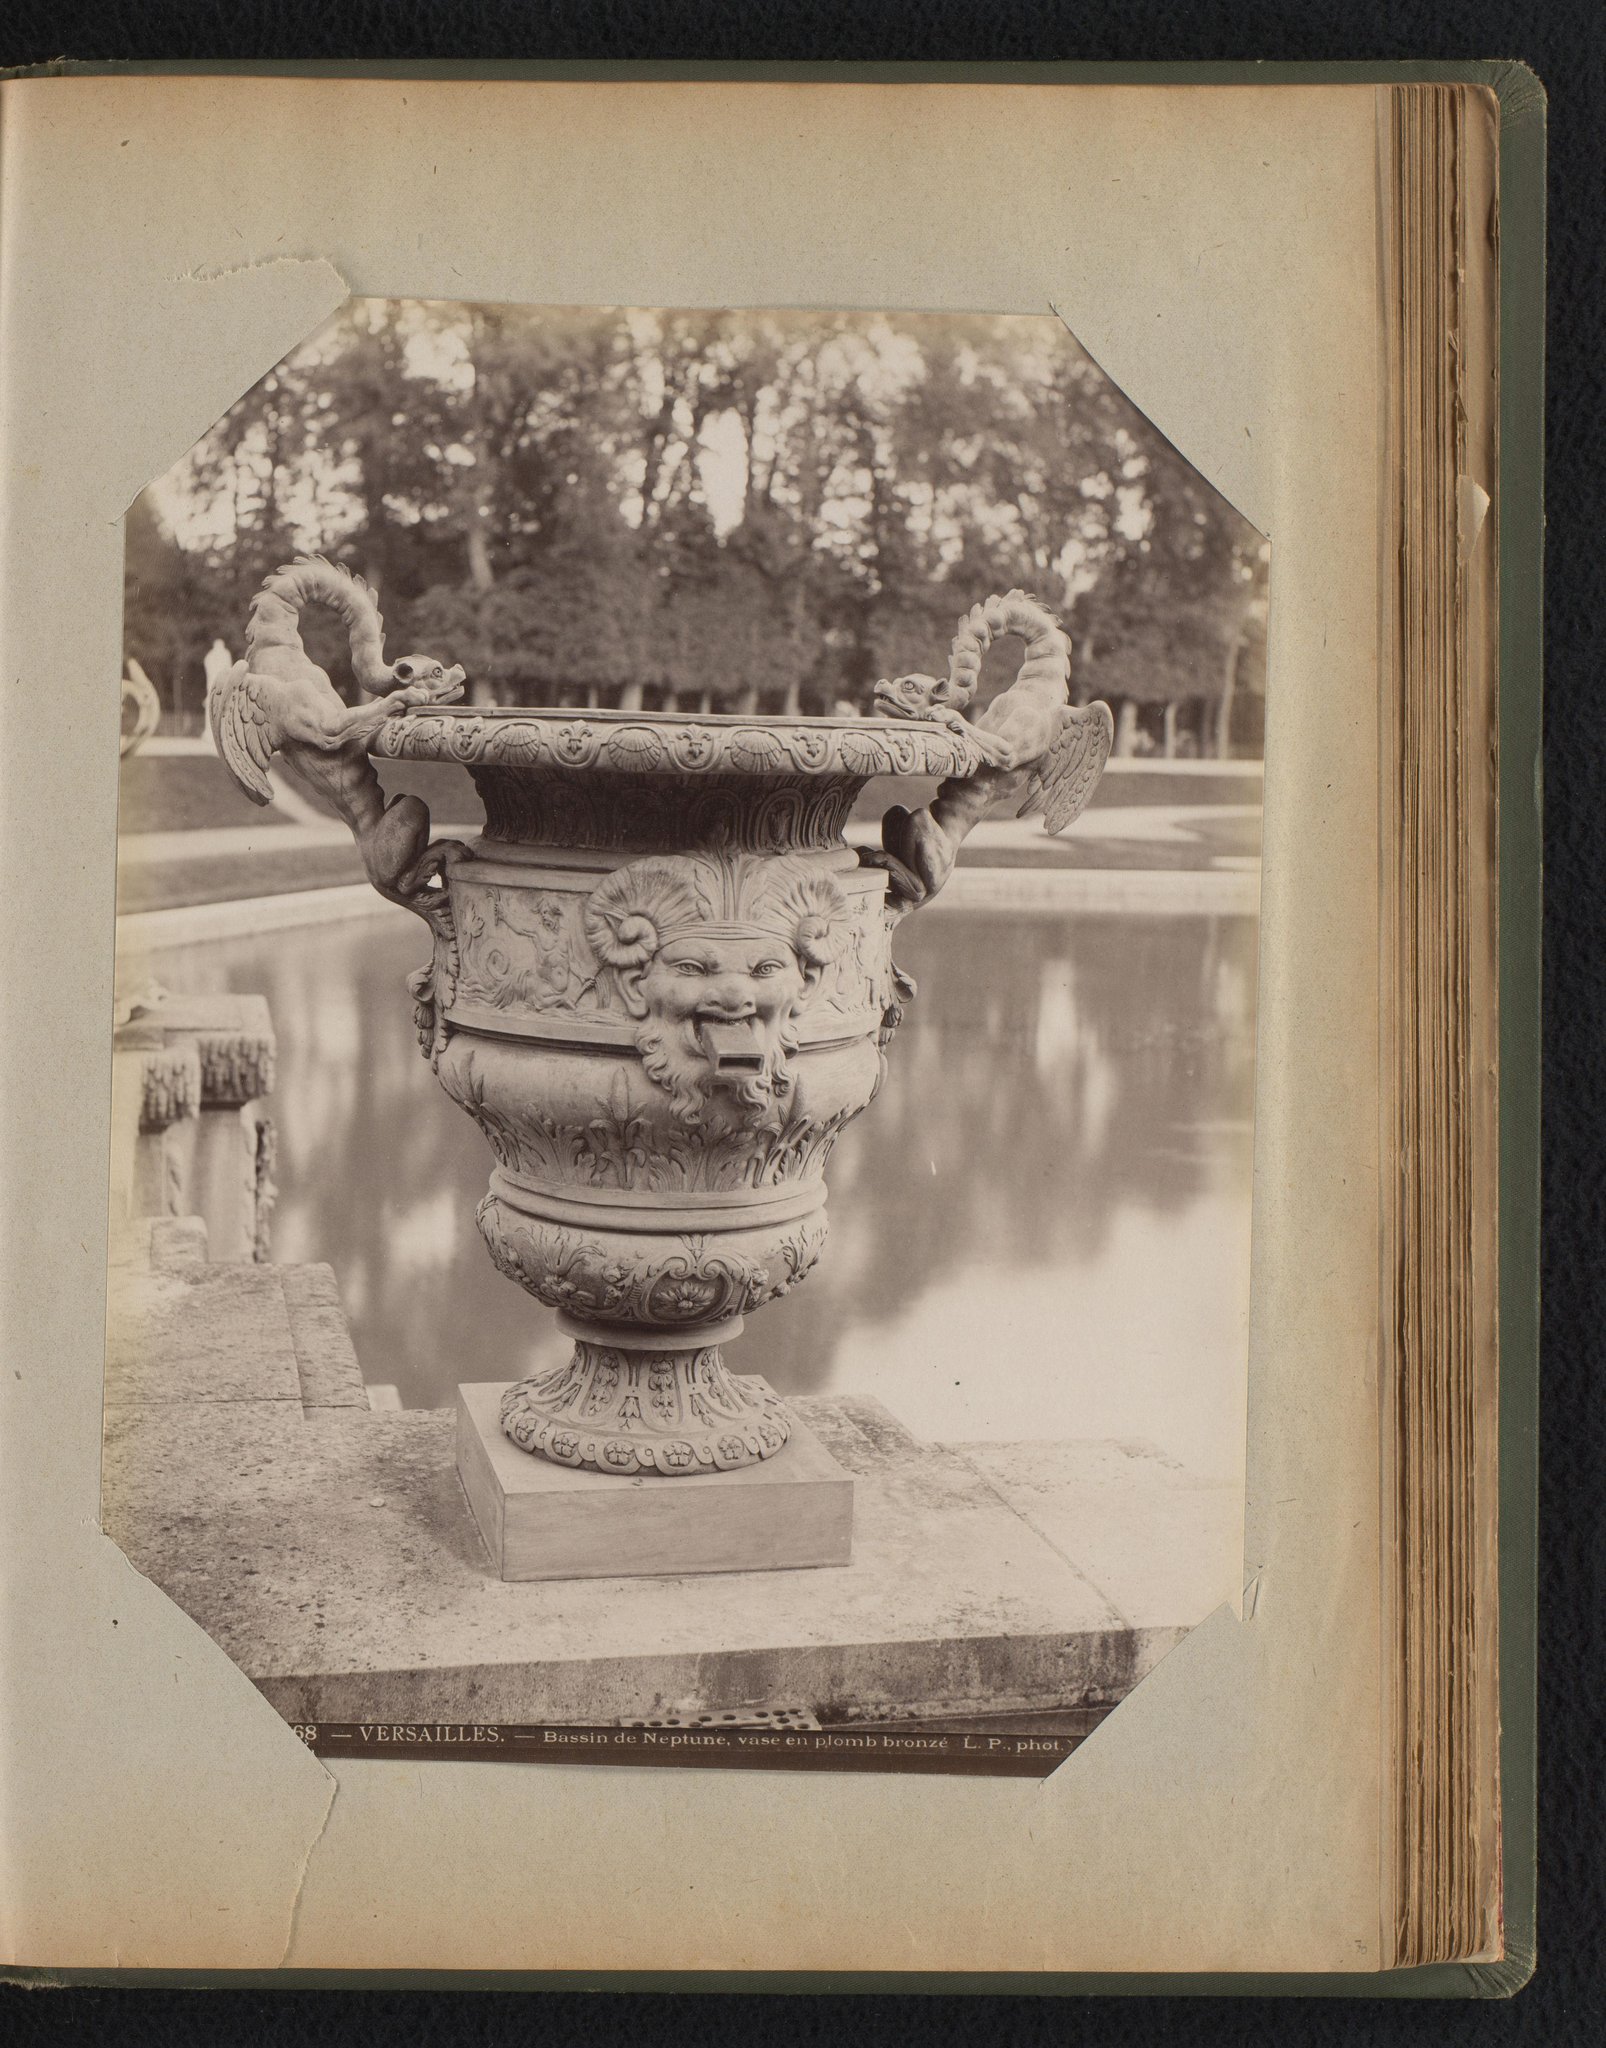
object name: photograph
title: Bronzen vaas met daarin verwerkt waterspuwers aan de rand van een bassin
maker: Anonymous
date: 1860-1900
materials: paper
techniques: albumen print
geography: france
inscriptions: annotation: ‘268 - Versailles - Bassin de Neptune, vase en plomp bronze L.P. Phot.’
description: Ter decoratie is op de vaas het hoofd van Pan aangebracht en twee draken die de oren van de vaas vormen. Onderdeel van een serie met betrekking tot het interieur van het paleis van Versailles met kroonluchters, deuren, portalen en meubelstukken.